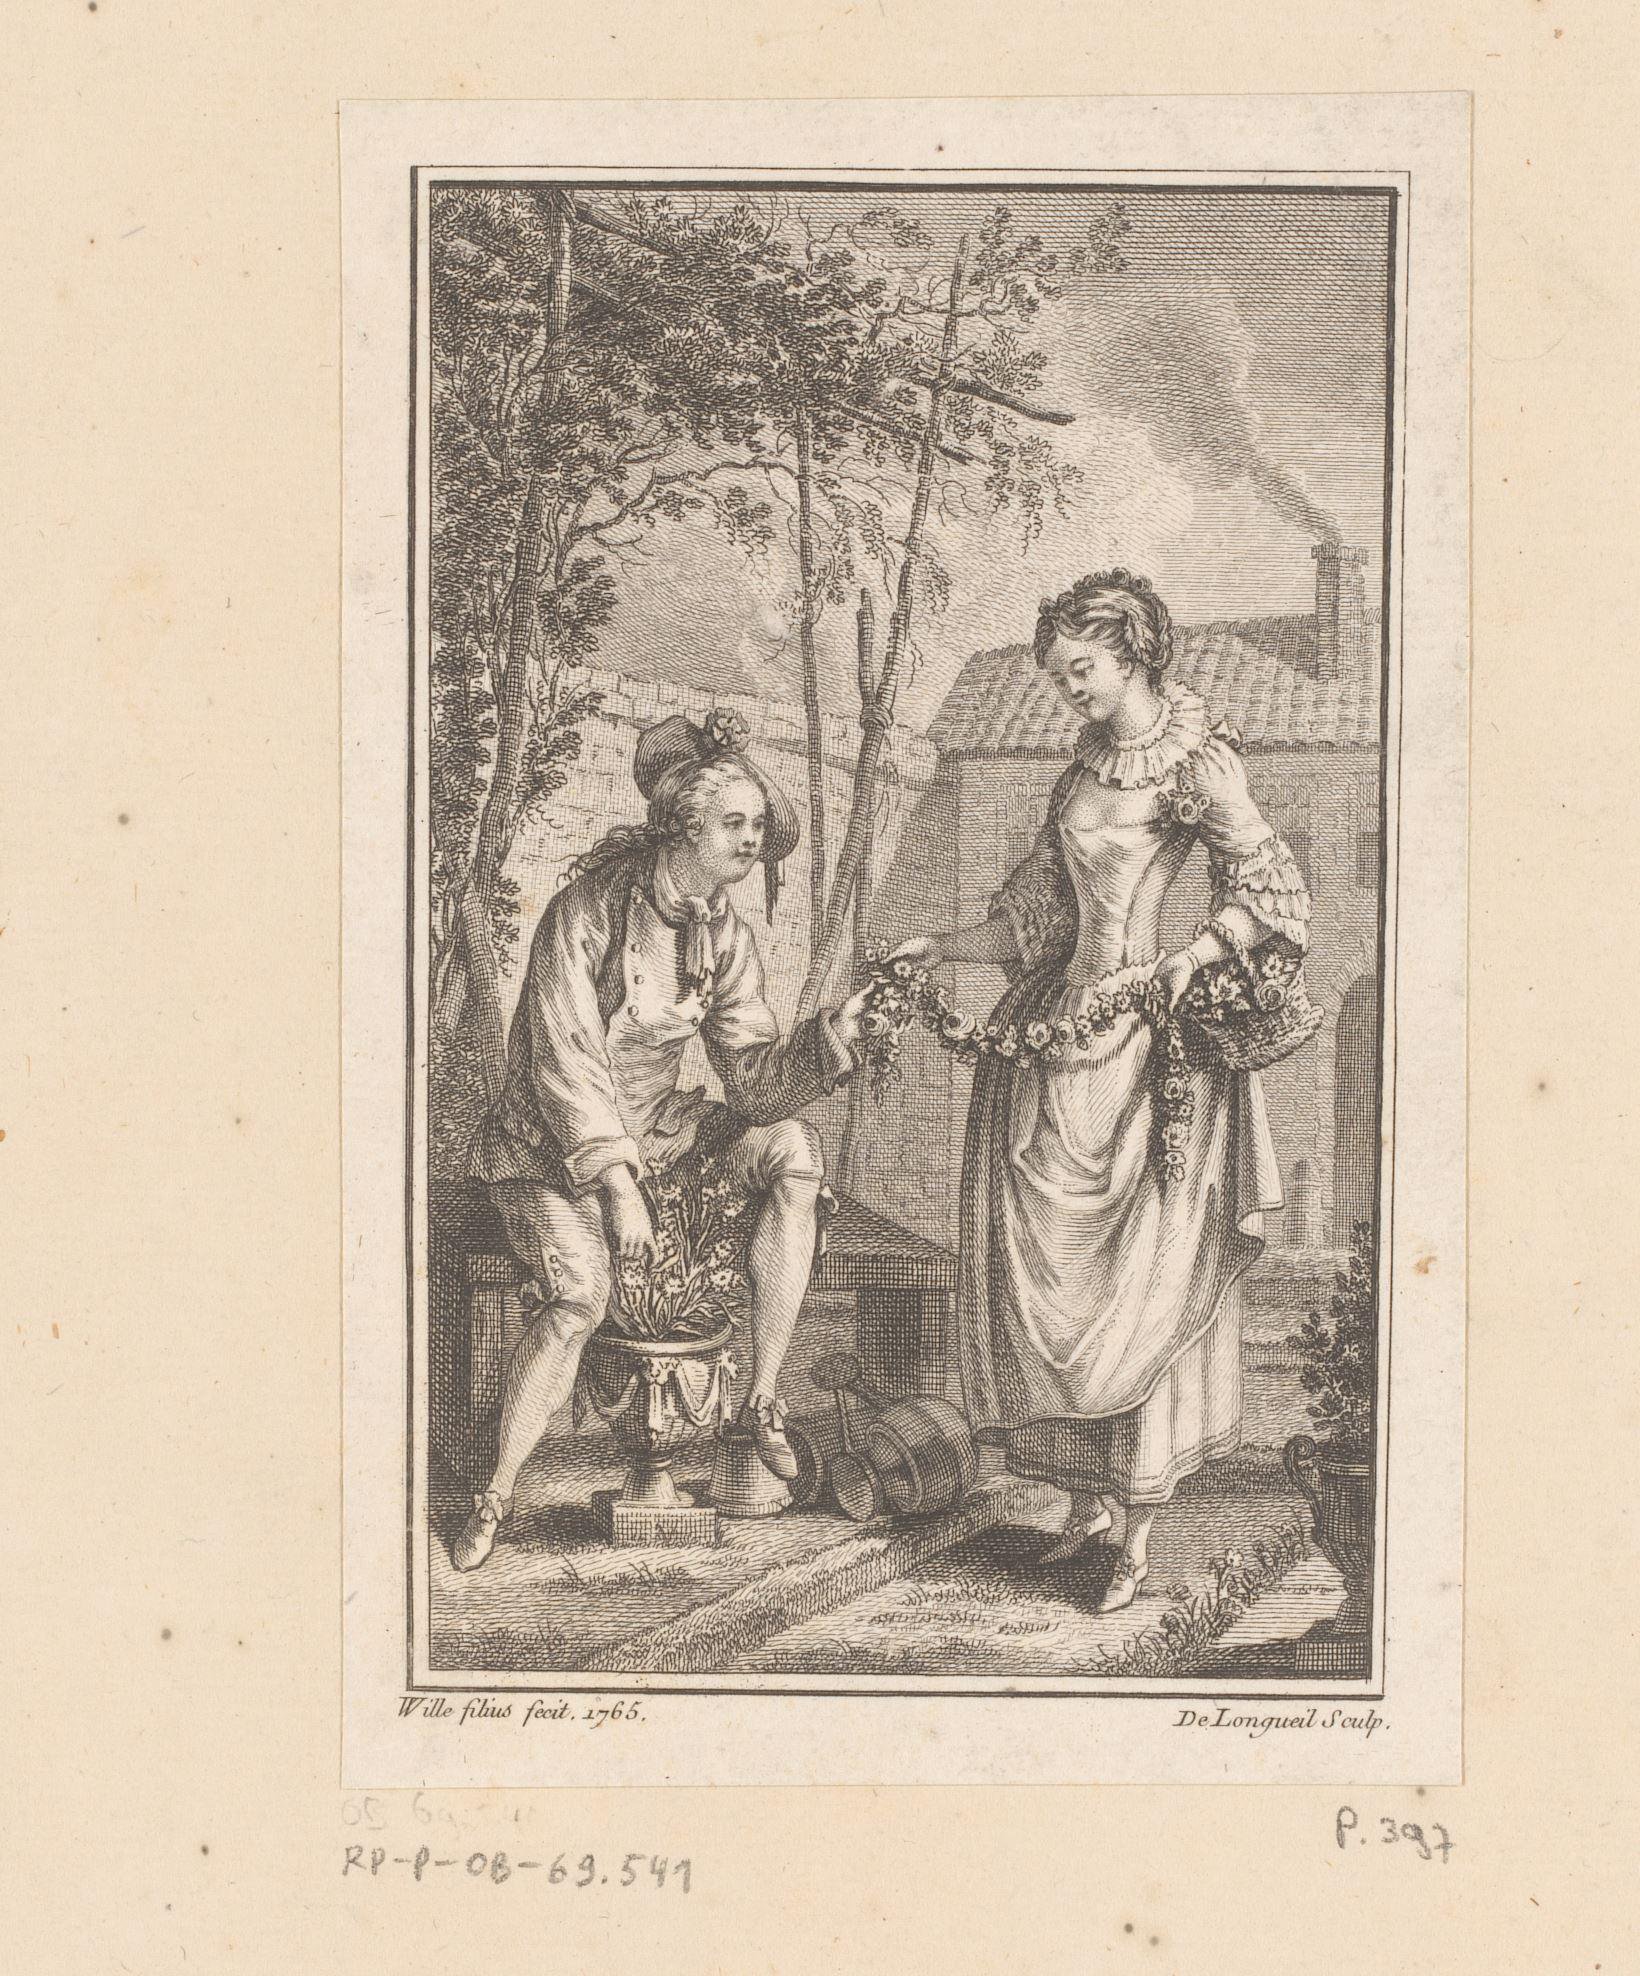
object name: print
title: Man en vrouw met een bloemenguirlande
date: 1765-1792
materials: paper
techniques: engraving, etching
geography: france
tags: garland, wreath, smell, smelling (one of the five senses)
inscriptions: collector's mark: Lugt 240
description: Mogelijk prent uit een boek of serie: 'Les sens'.